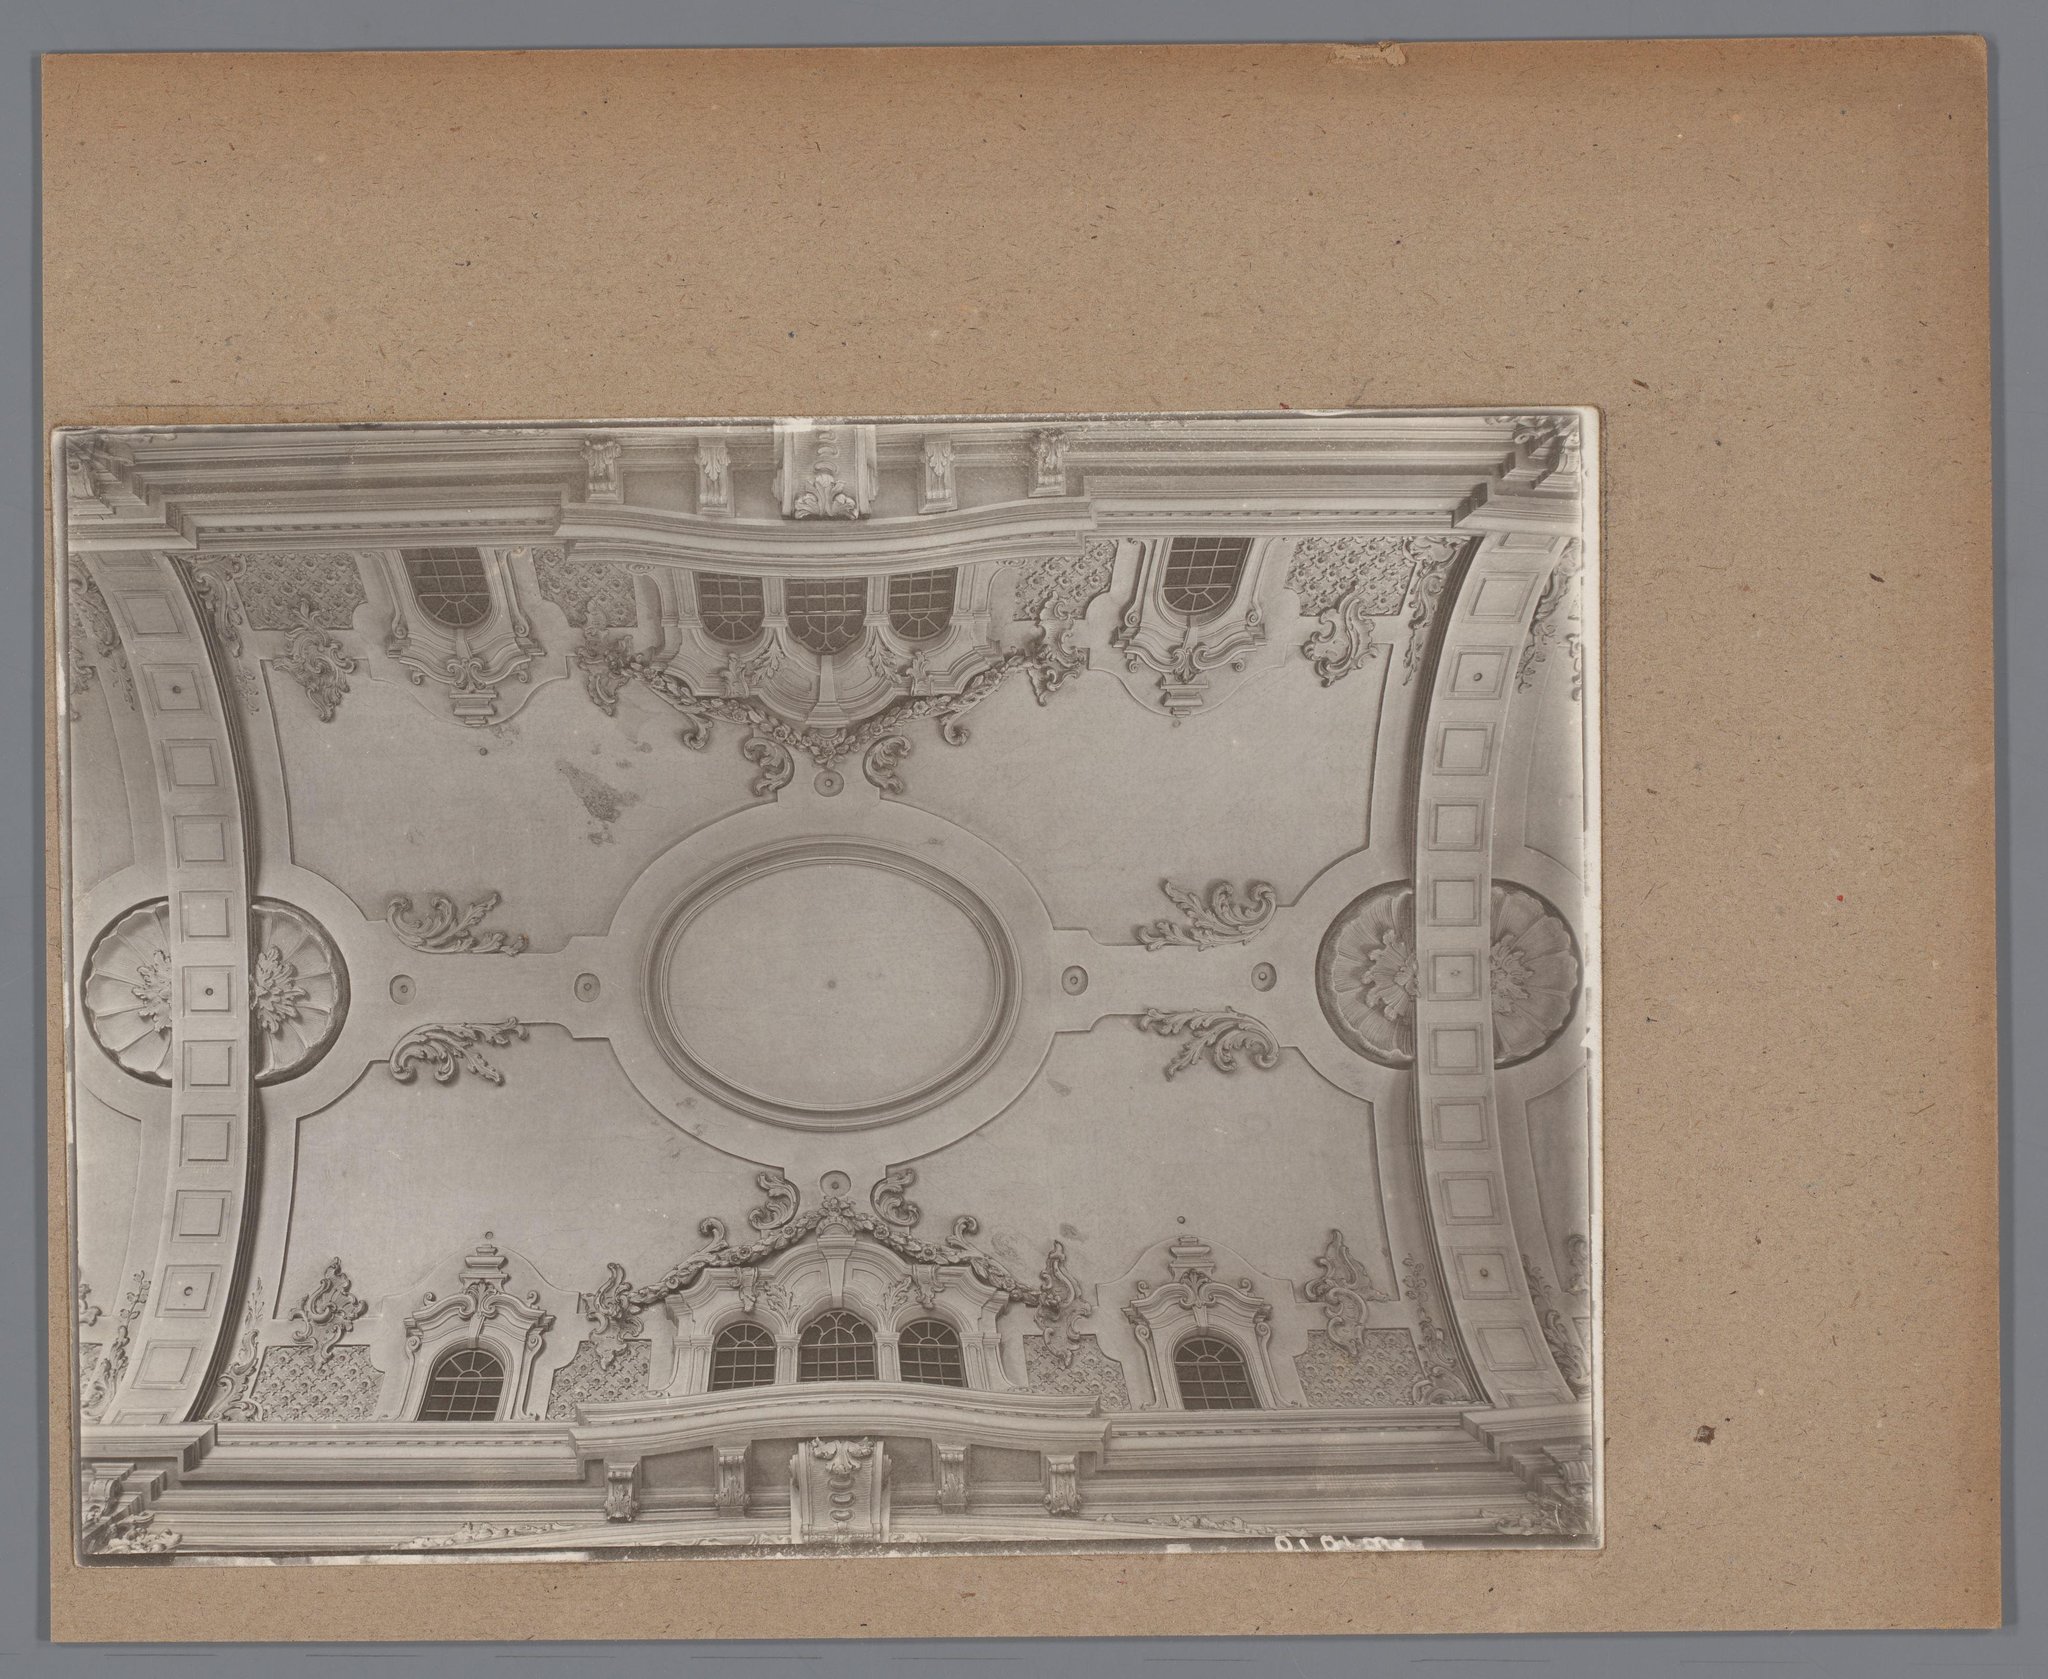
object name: photograph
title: Stucplafond v/d Gr. S. Michaëlskerk te Hamburg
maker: Anonymous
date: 1900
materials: paper, cardboard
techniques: gelatin silver print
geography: hamburg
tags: interior of church, (decorated) ceiling